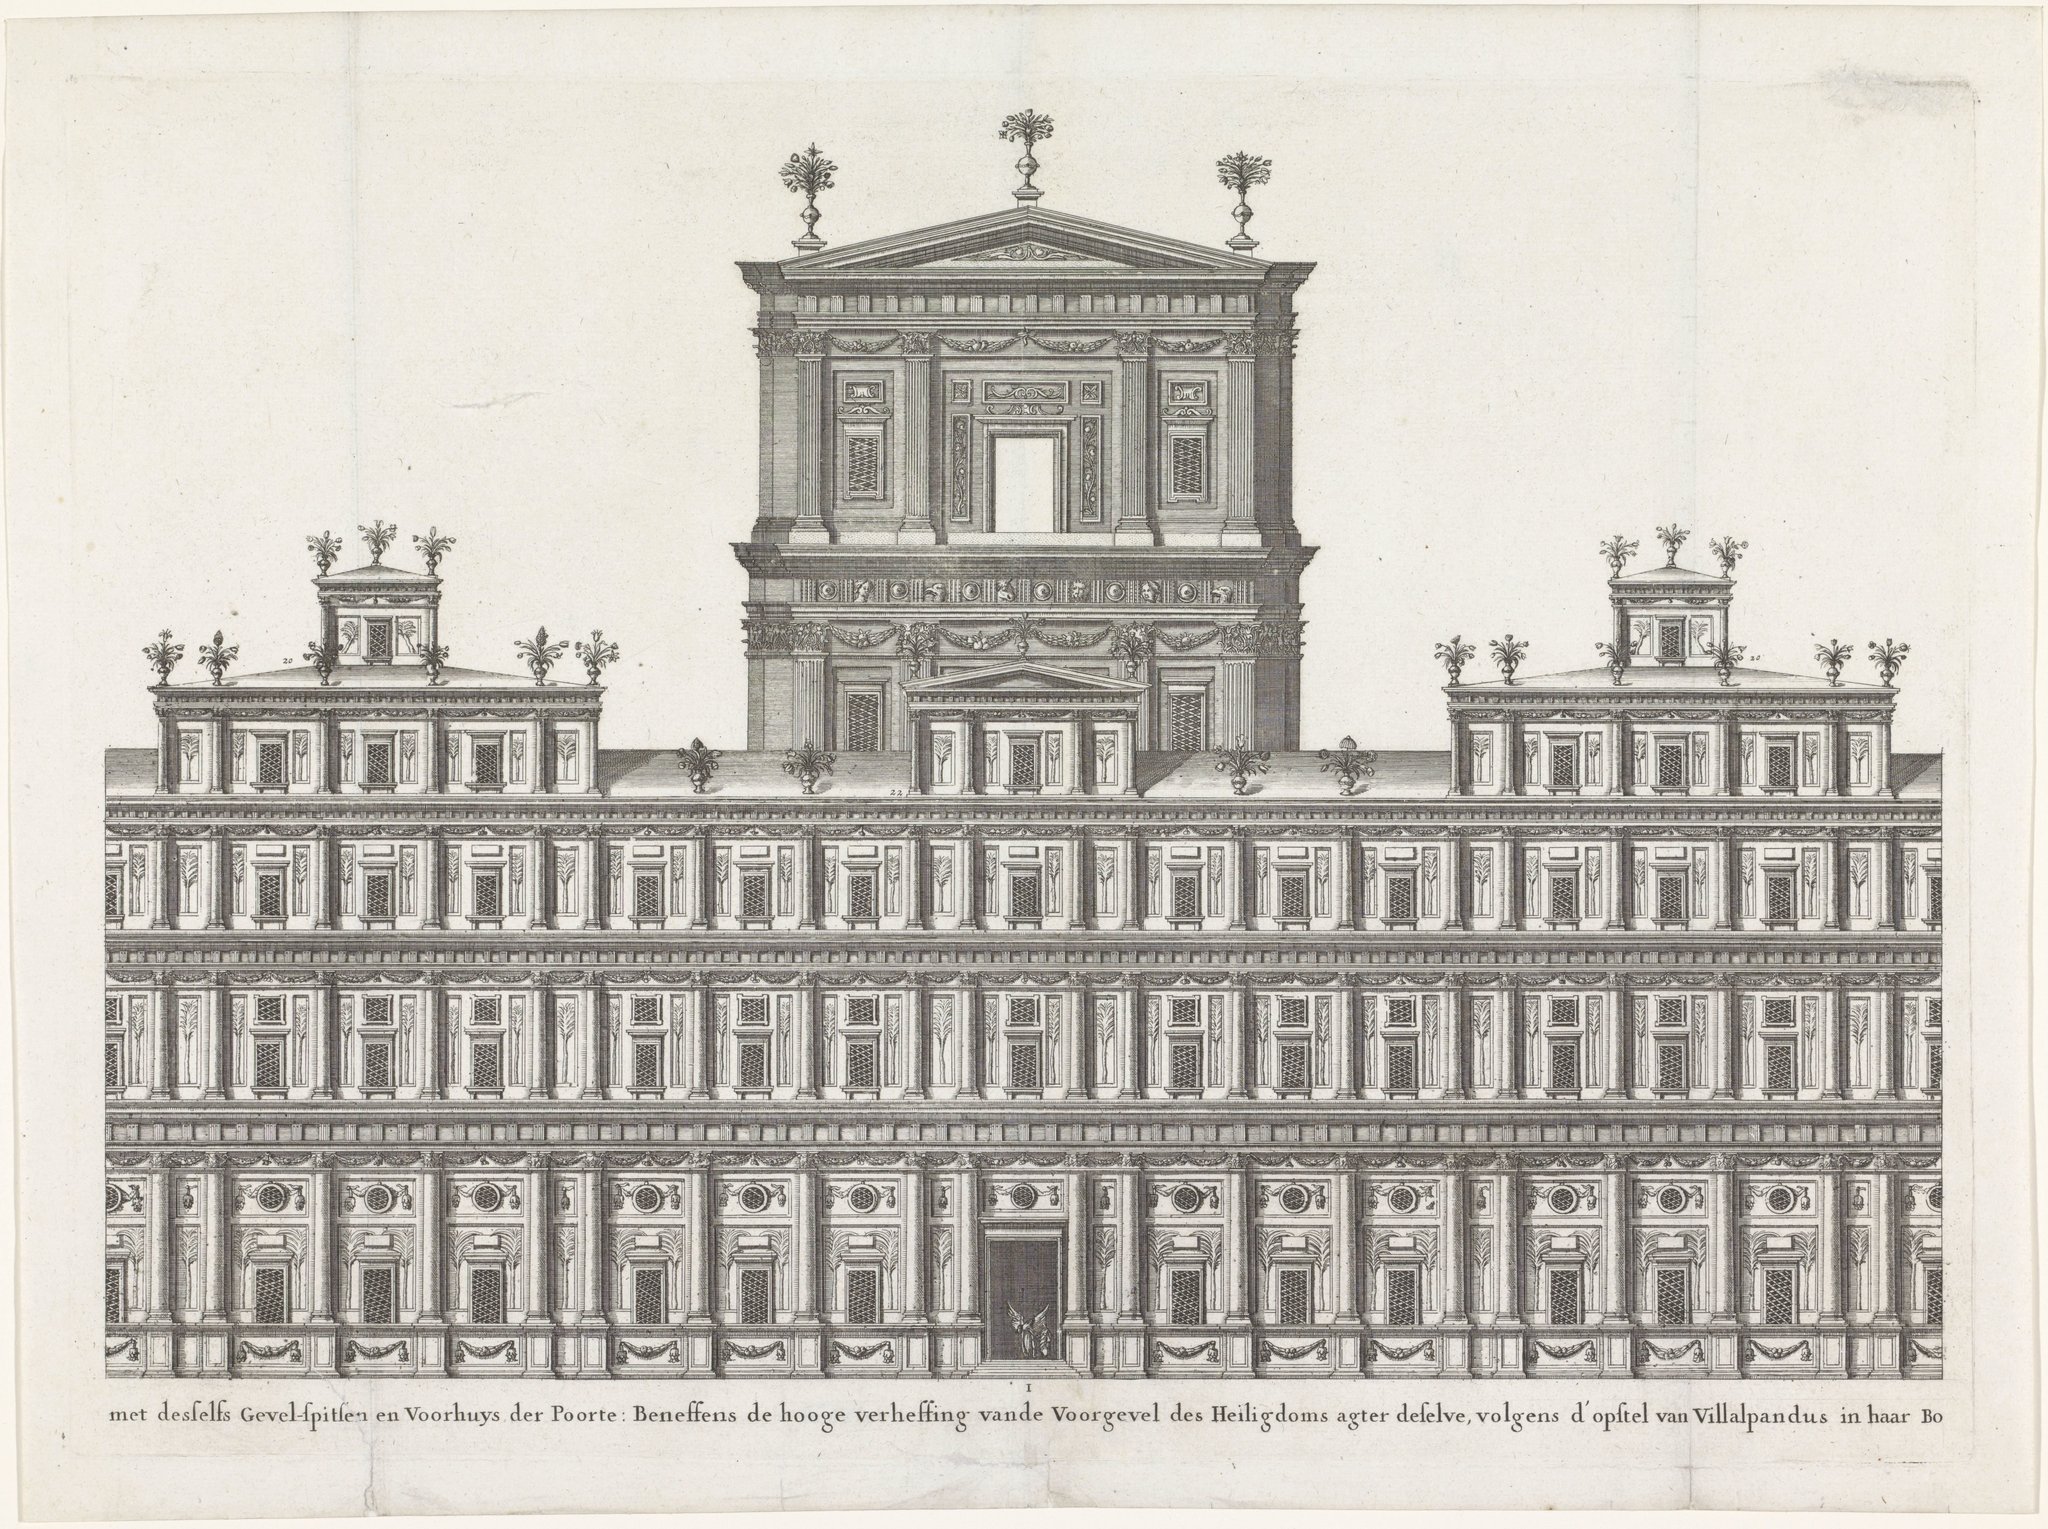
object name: print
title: Voorgevel van de nieuwe tempel (midden)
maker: Anonymous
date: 1618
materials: paper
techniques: etching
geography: netherlands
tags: outer court of jewish temple, with gates and stairs, temple of solomon (1 kings 5-9; 2 chronicles 2-7)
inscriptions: collector's mark: Lugt 2228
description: Het middendeel van de gevel van de nieuwe tempel te Jeruzalem, zoals deze eruit zou zien volgens Juan Bautista Villalpando in zijn boek Ezechielem Explanationes, 1596. Villalpando baseerde zich op de visioenen van Ezechiël over de nieuwe tempel in het Bijbelboek Ezechiël. In de deuropening een engel met meetlat en de profeet Ezechiël.